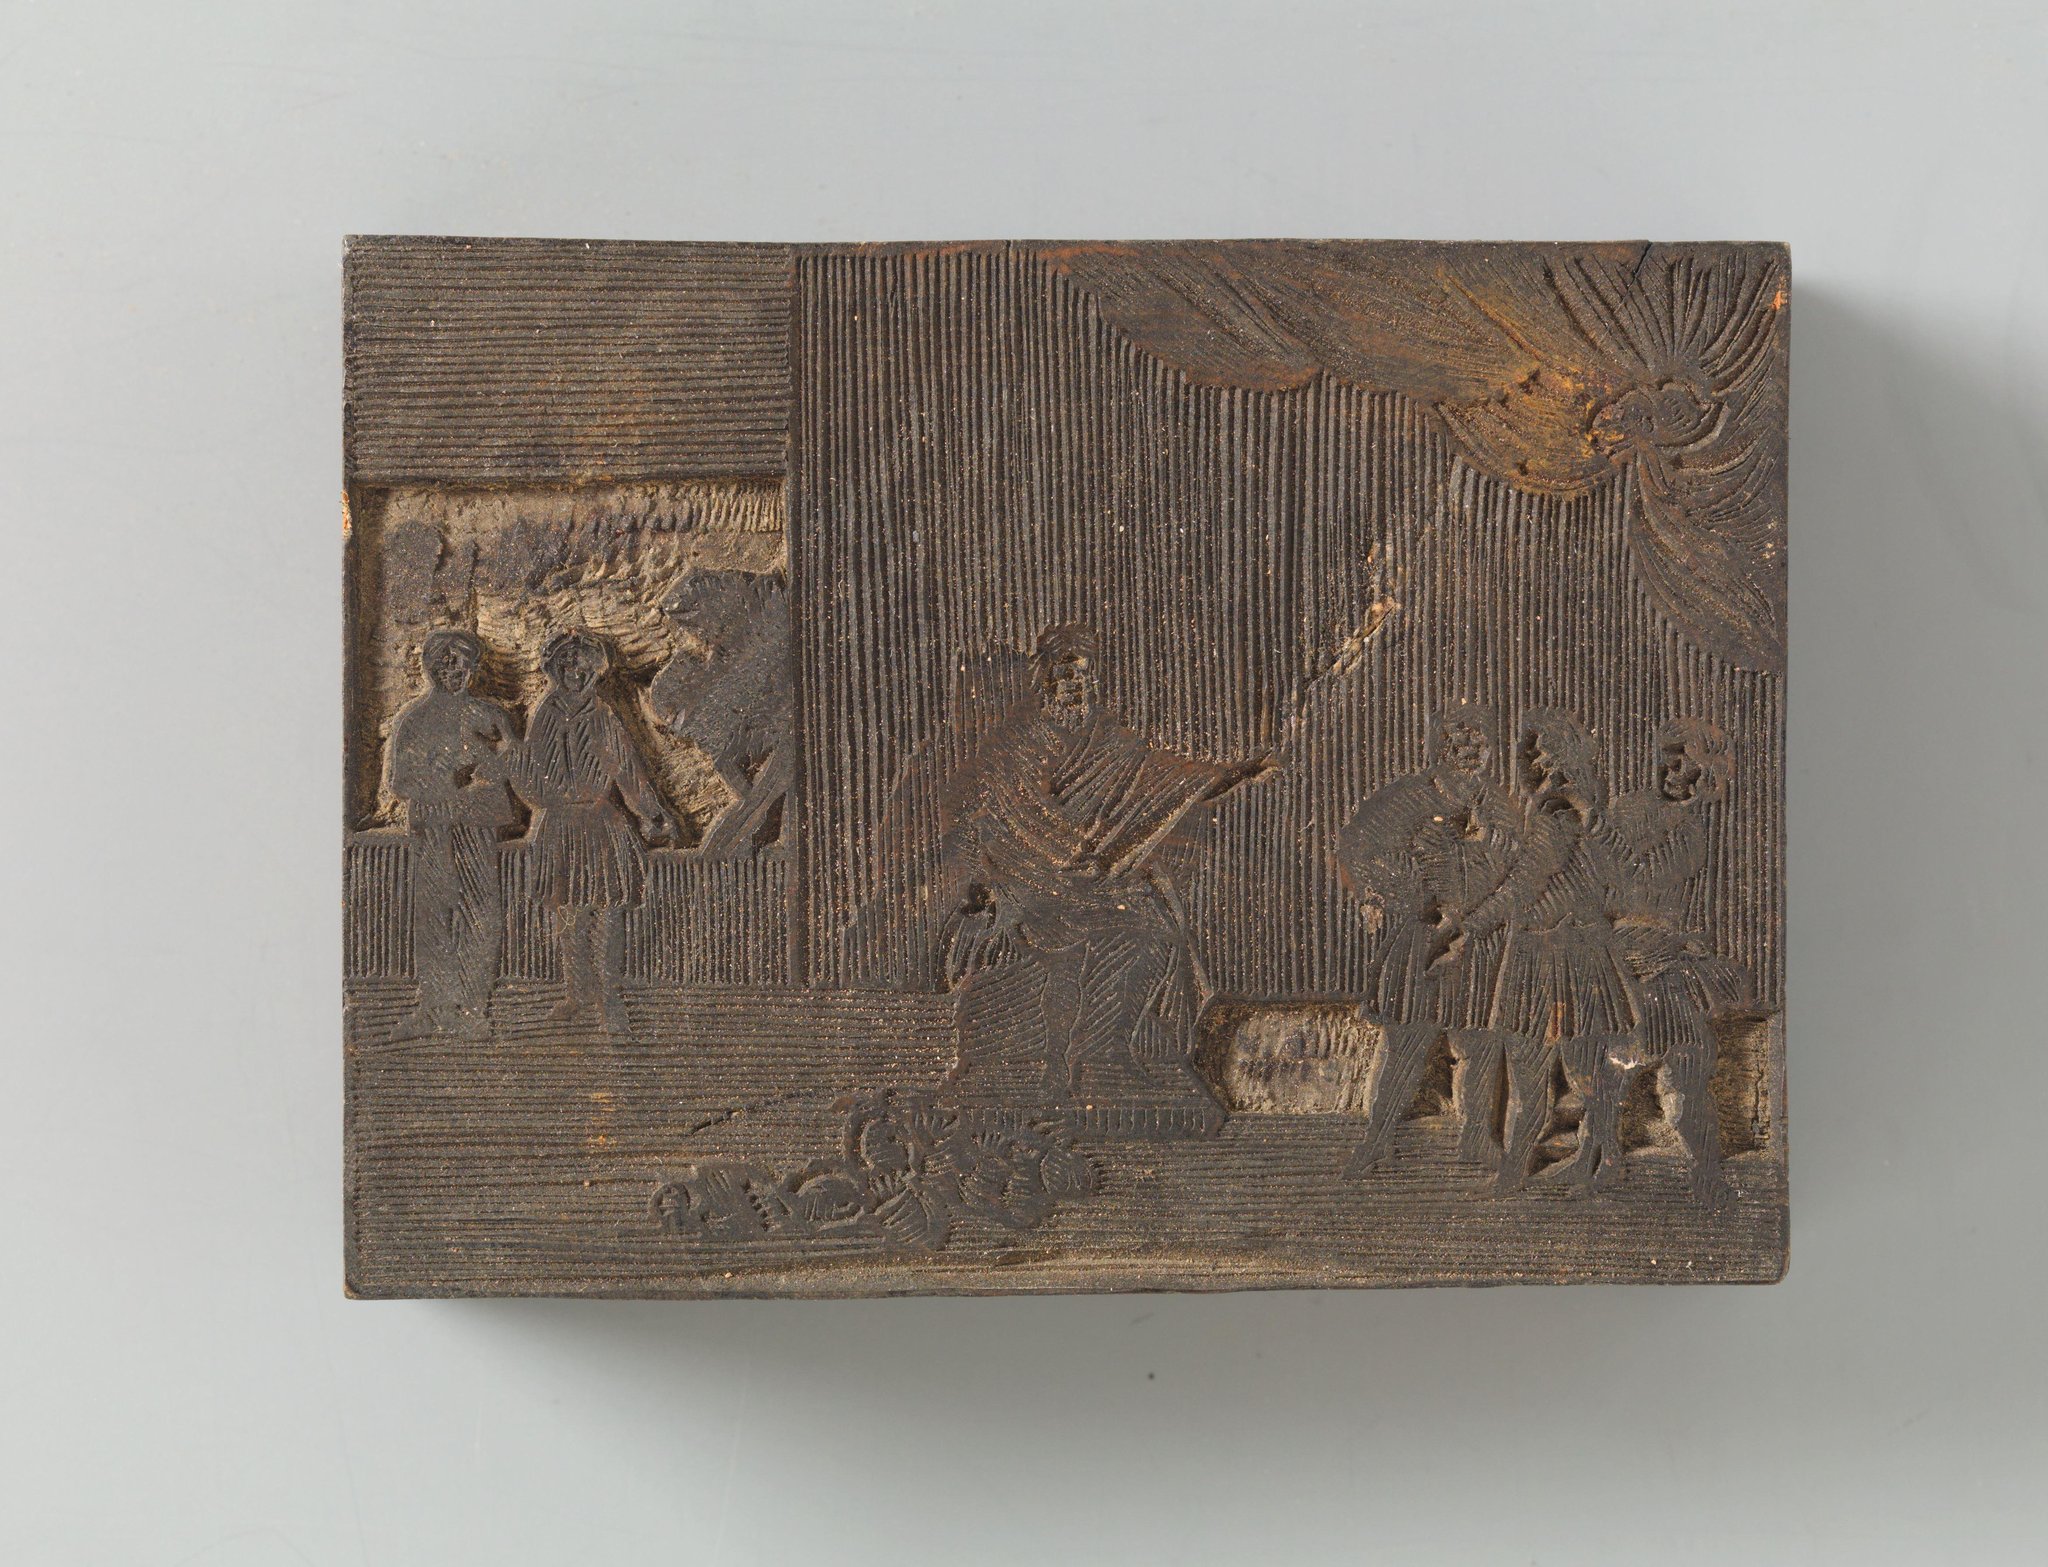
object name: wood block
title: Bijbel-illustraties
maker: Anonymous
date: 1550-1699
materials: wood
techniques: woodcut